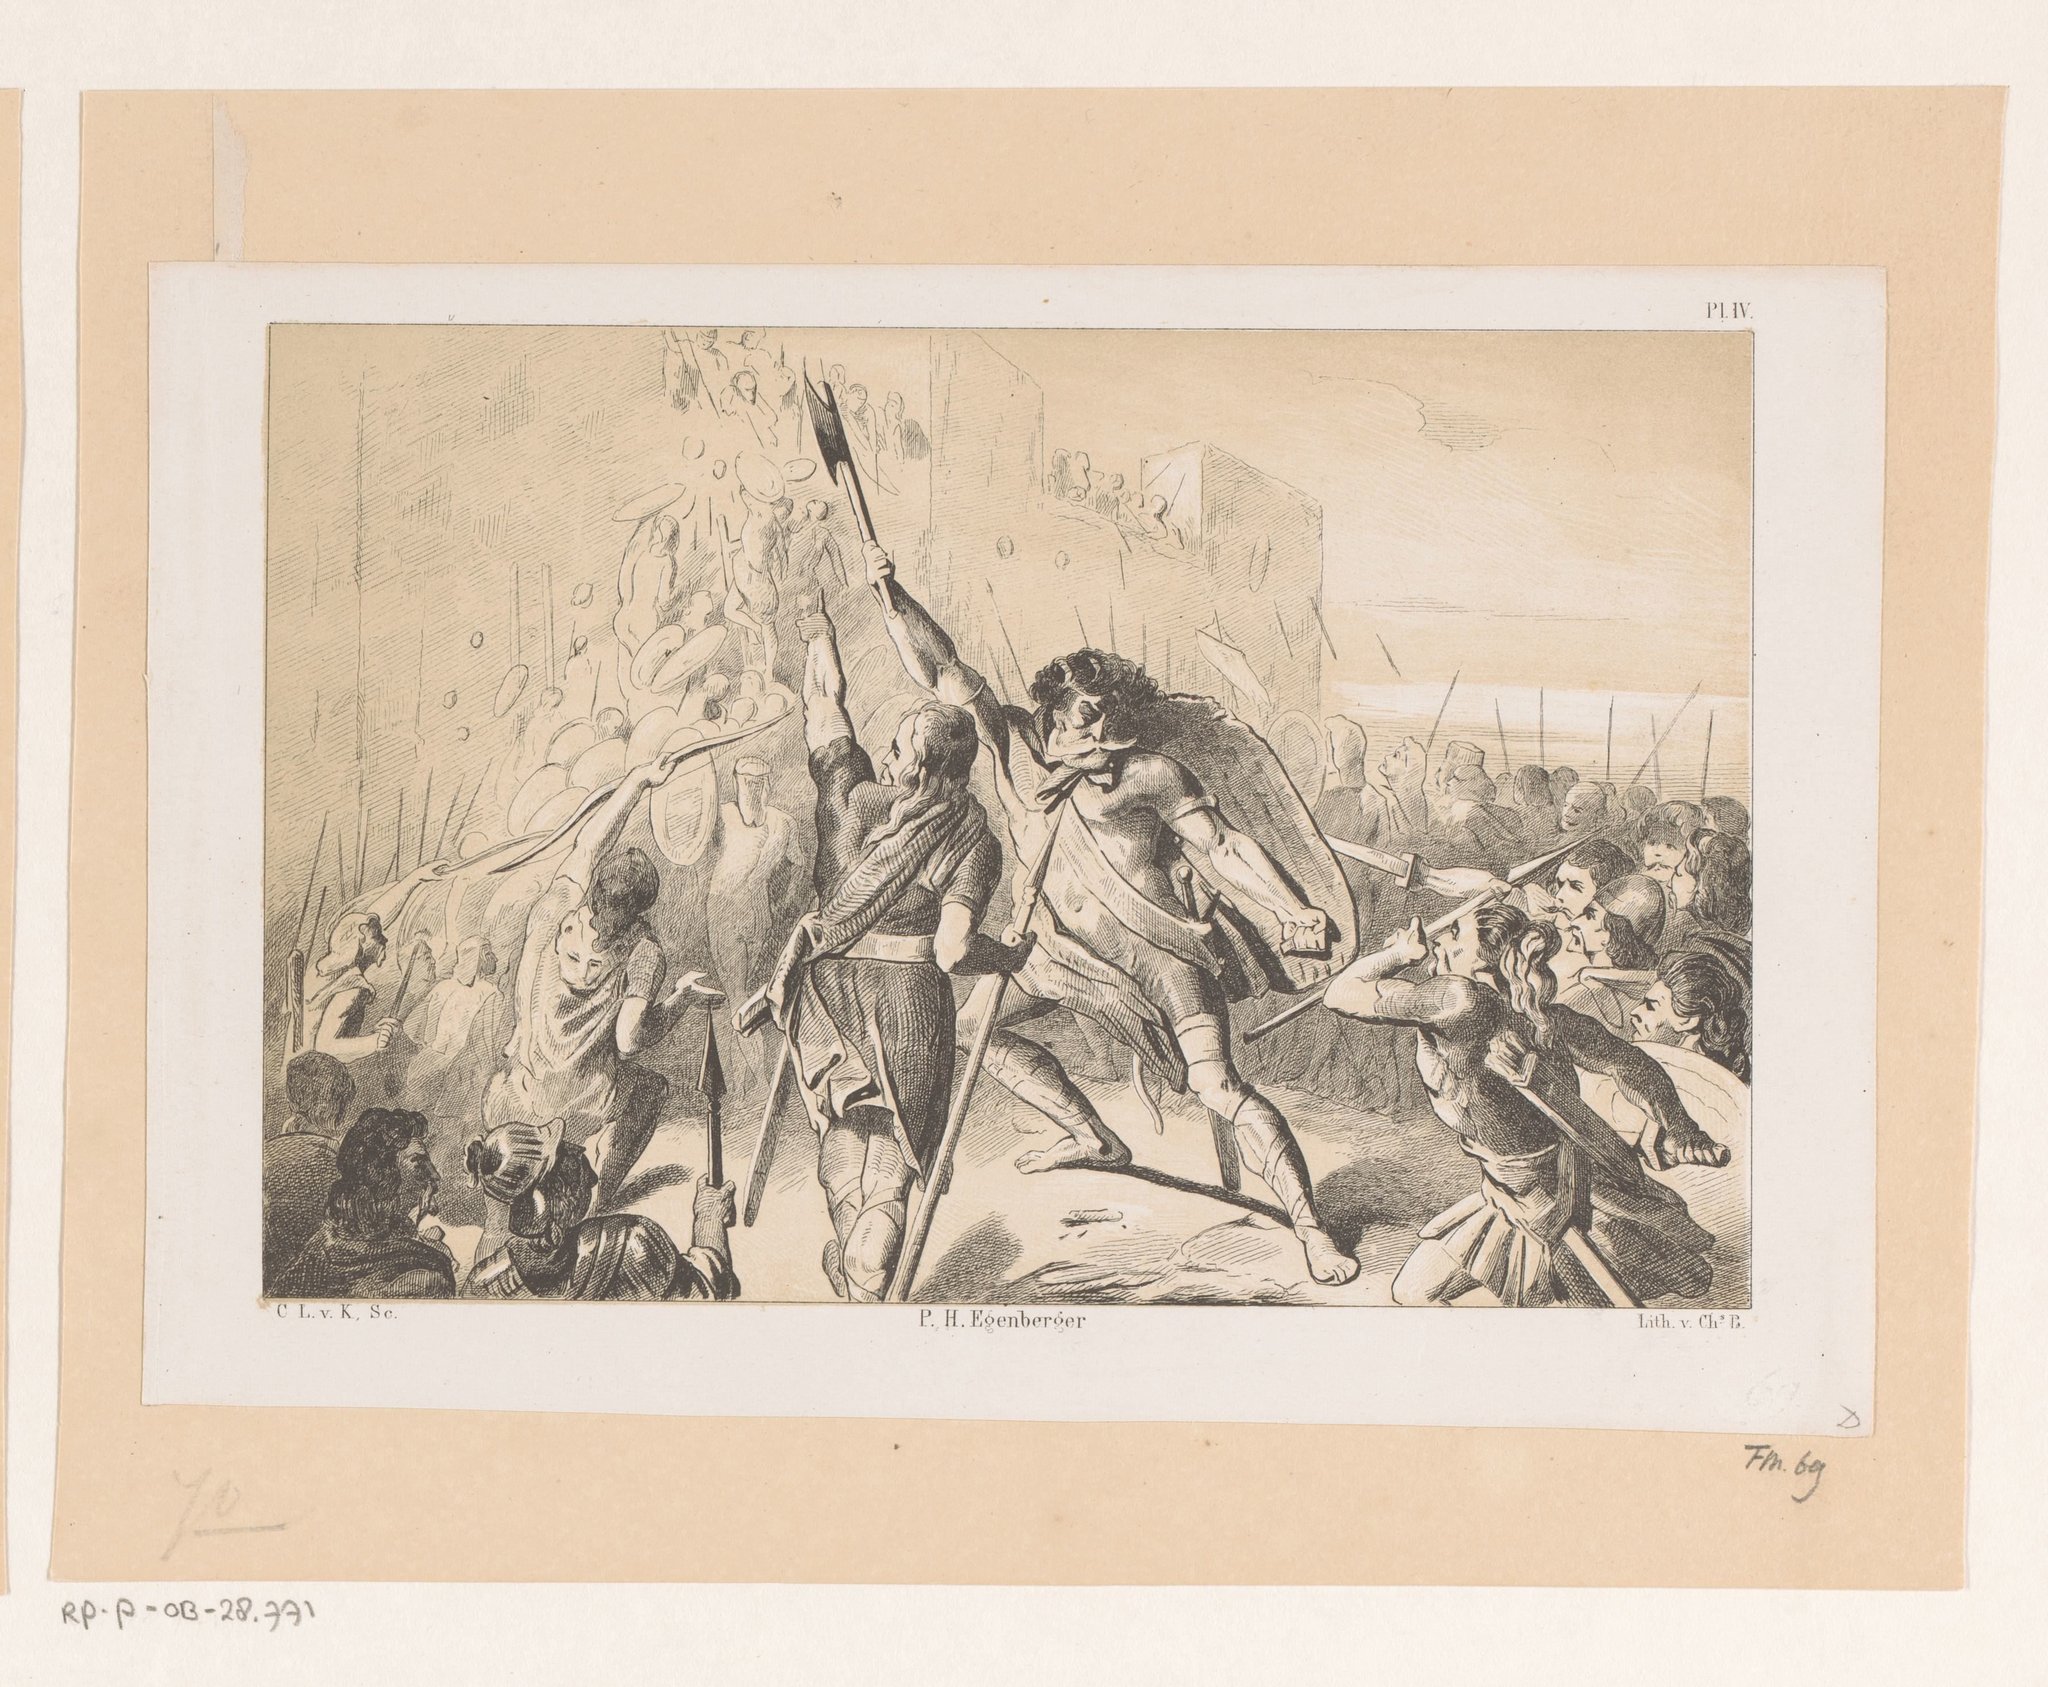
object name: print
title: Claudius Civilis bestormt de Romeinse legerplaats Vetera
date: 1855-1861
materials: paper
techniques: tone lithography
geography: netherlands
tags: signal to attack, walls ~ fortified city, (military) attack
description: Illustratie voor: Lennep, Jacob van 'De geschiedenis des vaderlands in schetsen en afbeeldingen' Amsterdam, M.H. Binger & Zonen, 1855-1861, 8 delen. Volgens Frederik Muller was Charles Binger gevestigd in Haarlem.